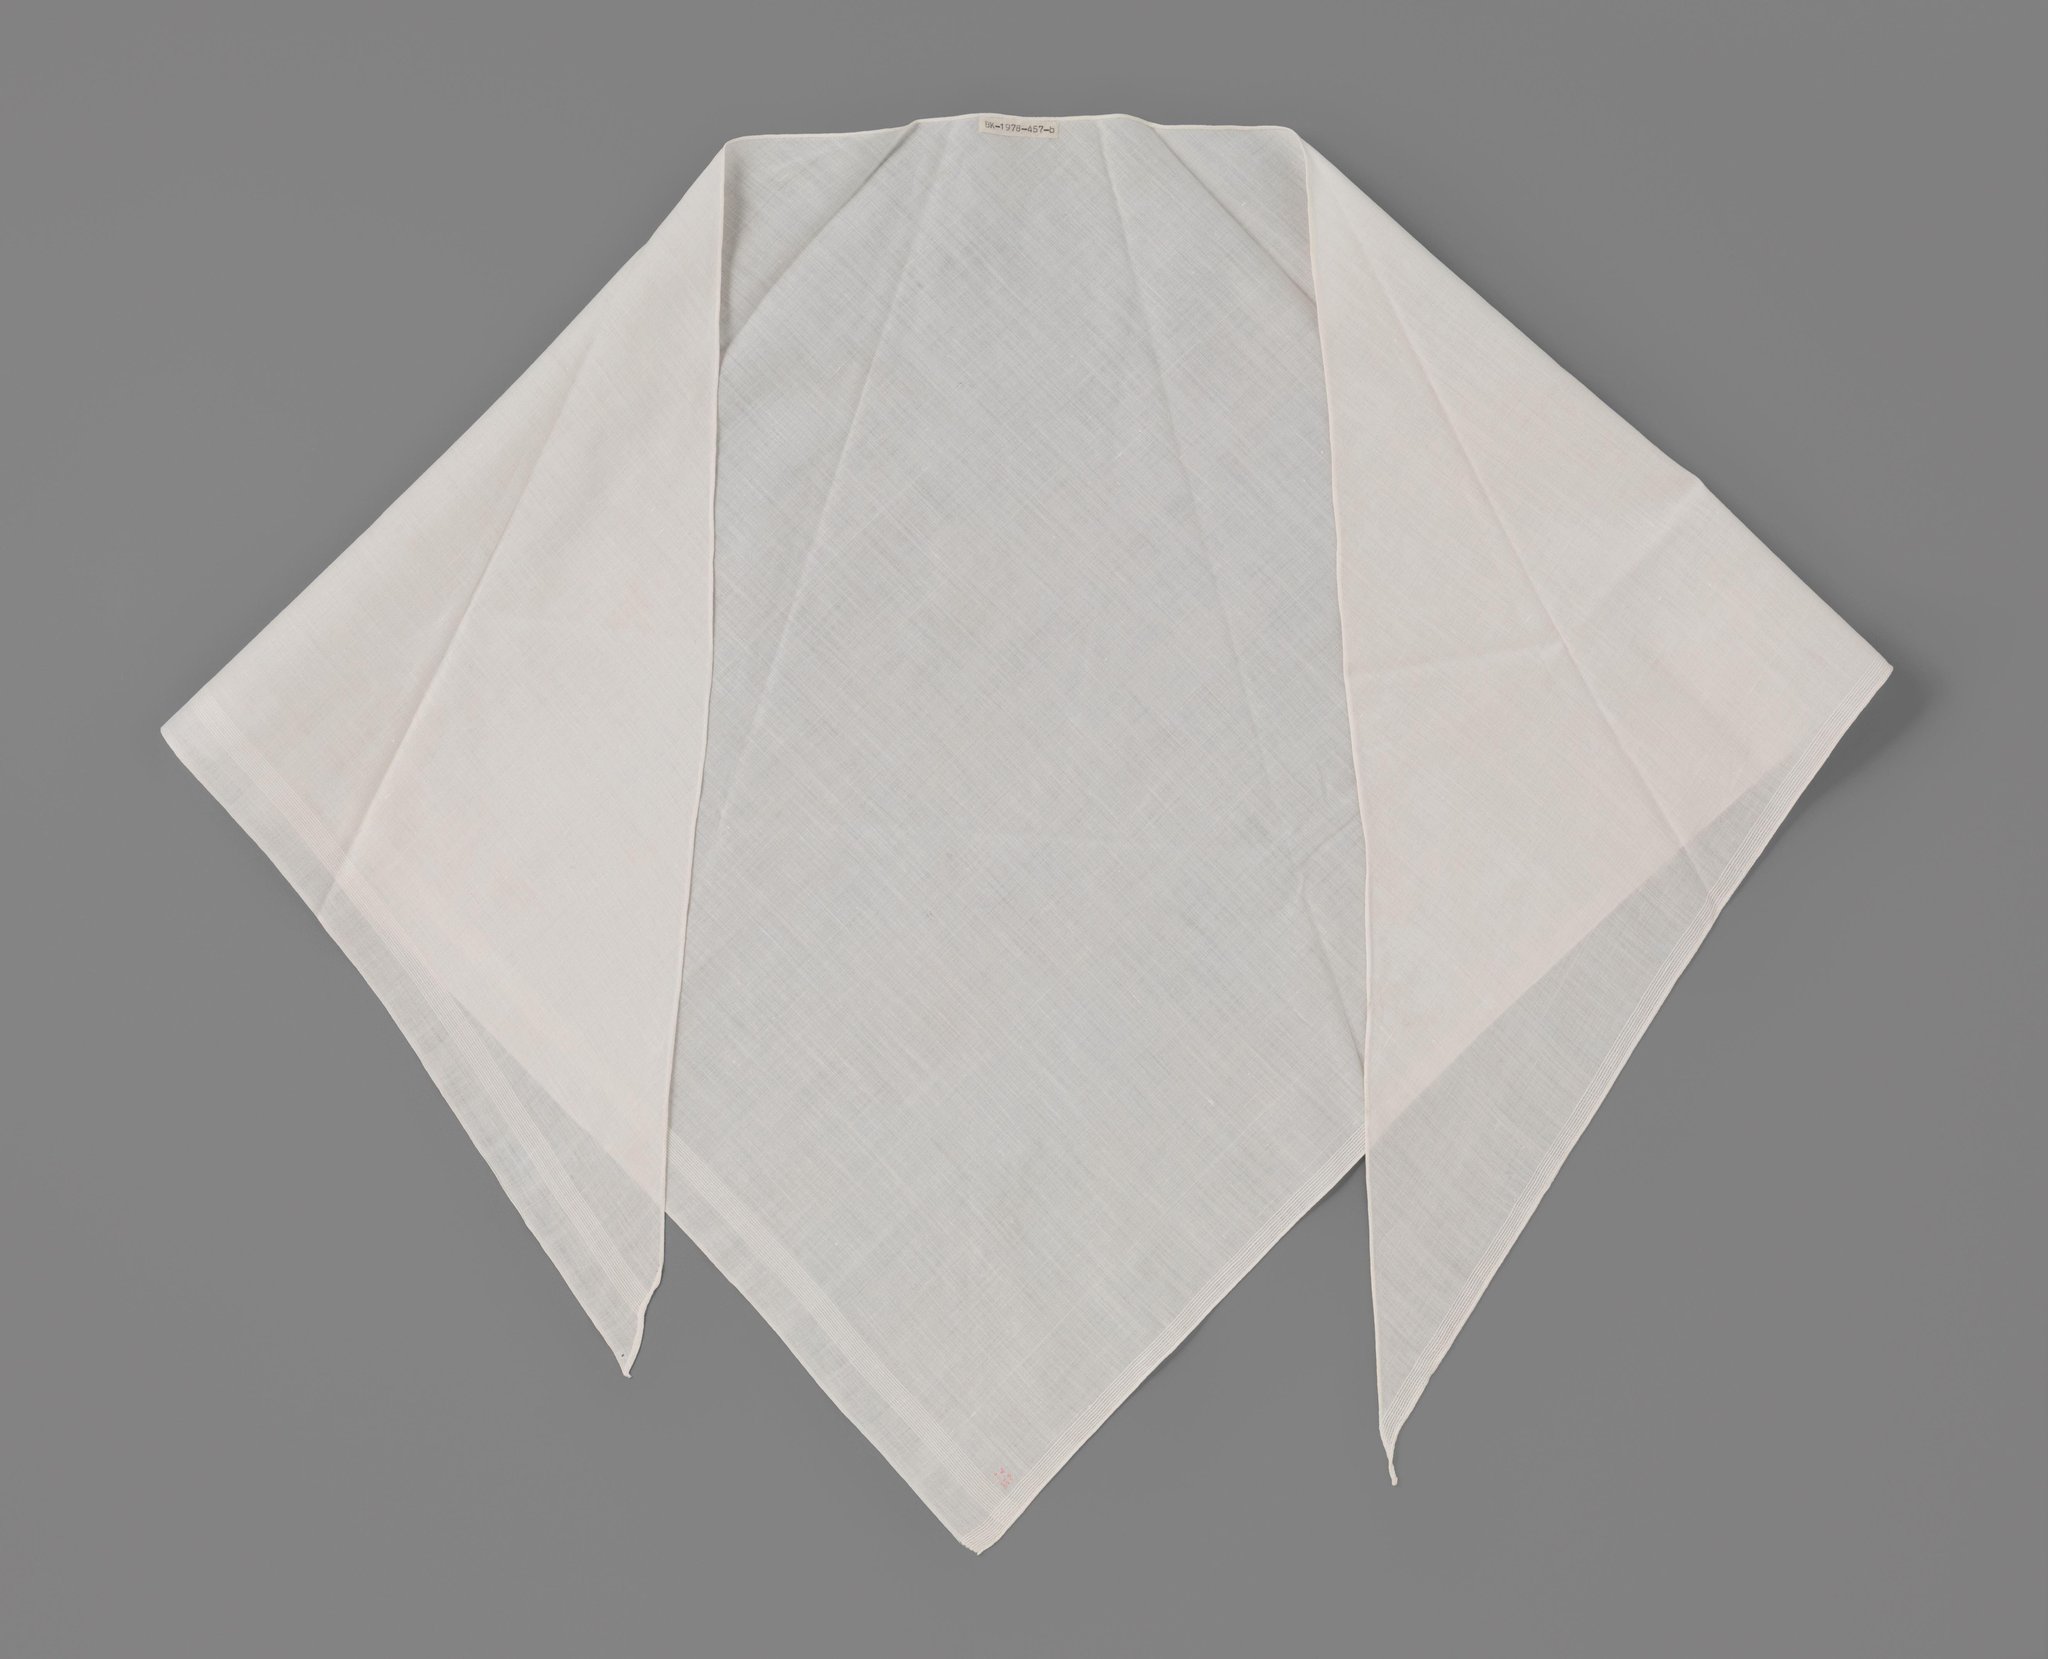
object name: fichu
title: Fichu van katoen, driehoekig met rondom een rand van streepbiezen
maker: Anonymous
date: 1890-1900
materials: cotton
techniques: cross stitching, weave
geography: amsterdam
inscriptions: mark: ‘NS/ 24’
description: Fichu van katoen, driehoekig met rondom een rand van streepbiezen. Model: een zijde zelfkant, overige twee platte zoom. Schuin op de draad gewerkt. In de punt met kleine rode kruissteken gemerkt "NS/ 24"voor mevrouw H.M.A.F. (Nine) Six-Bosch Reitz.